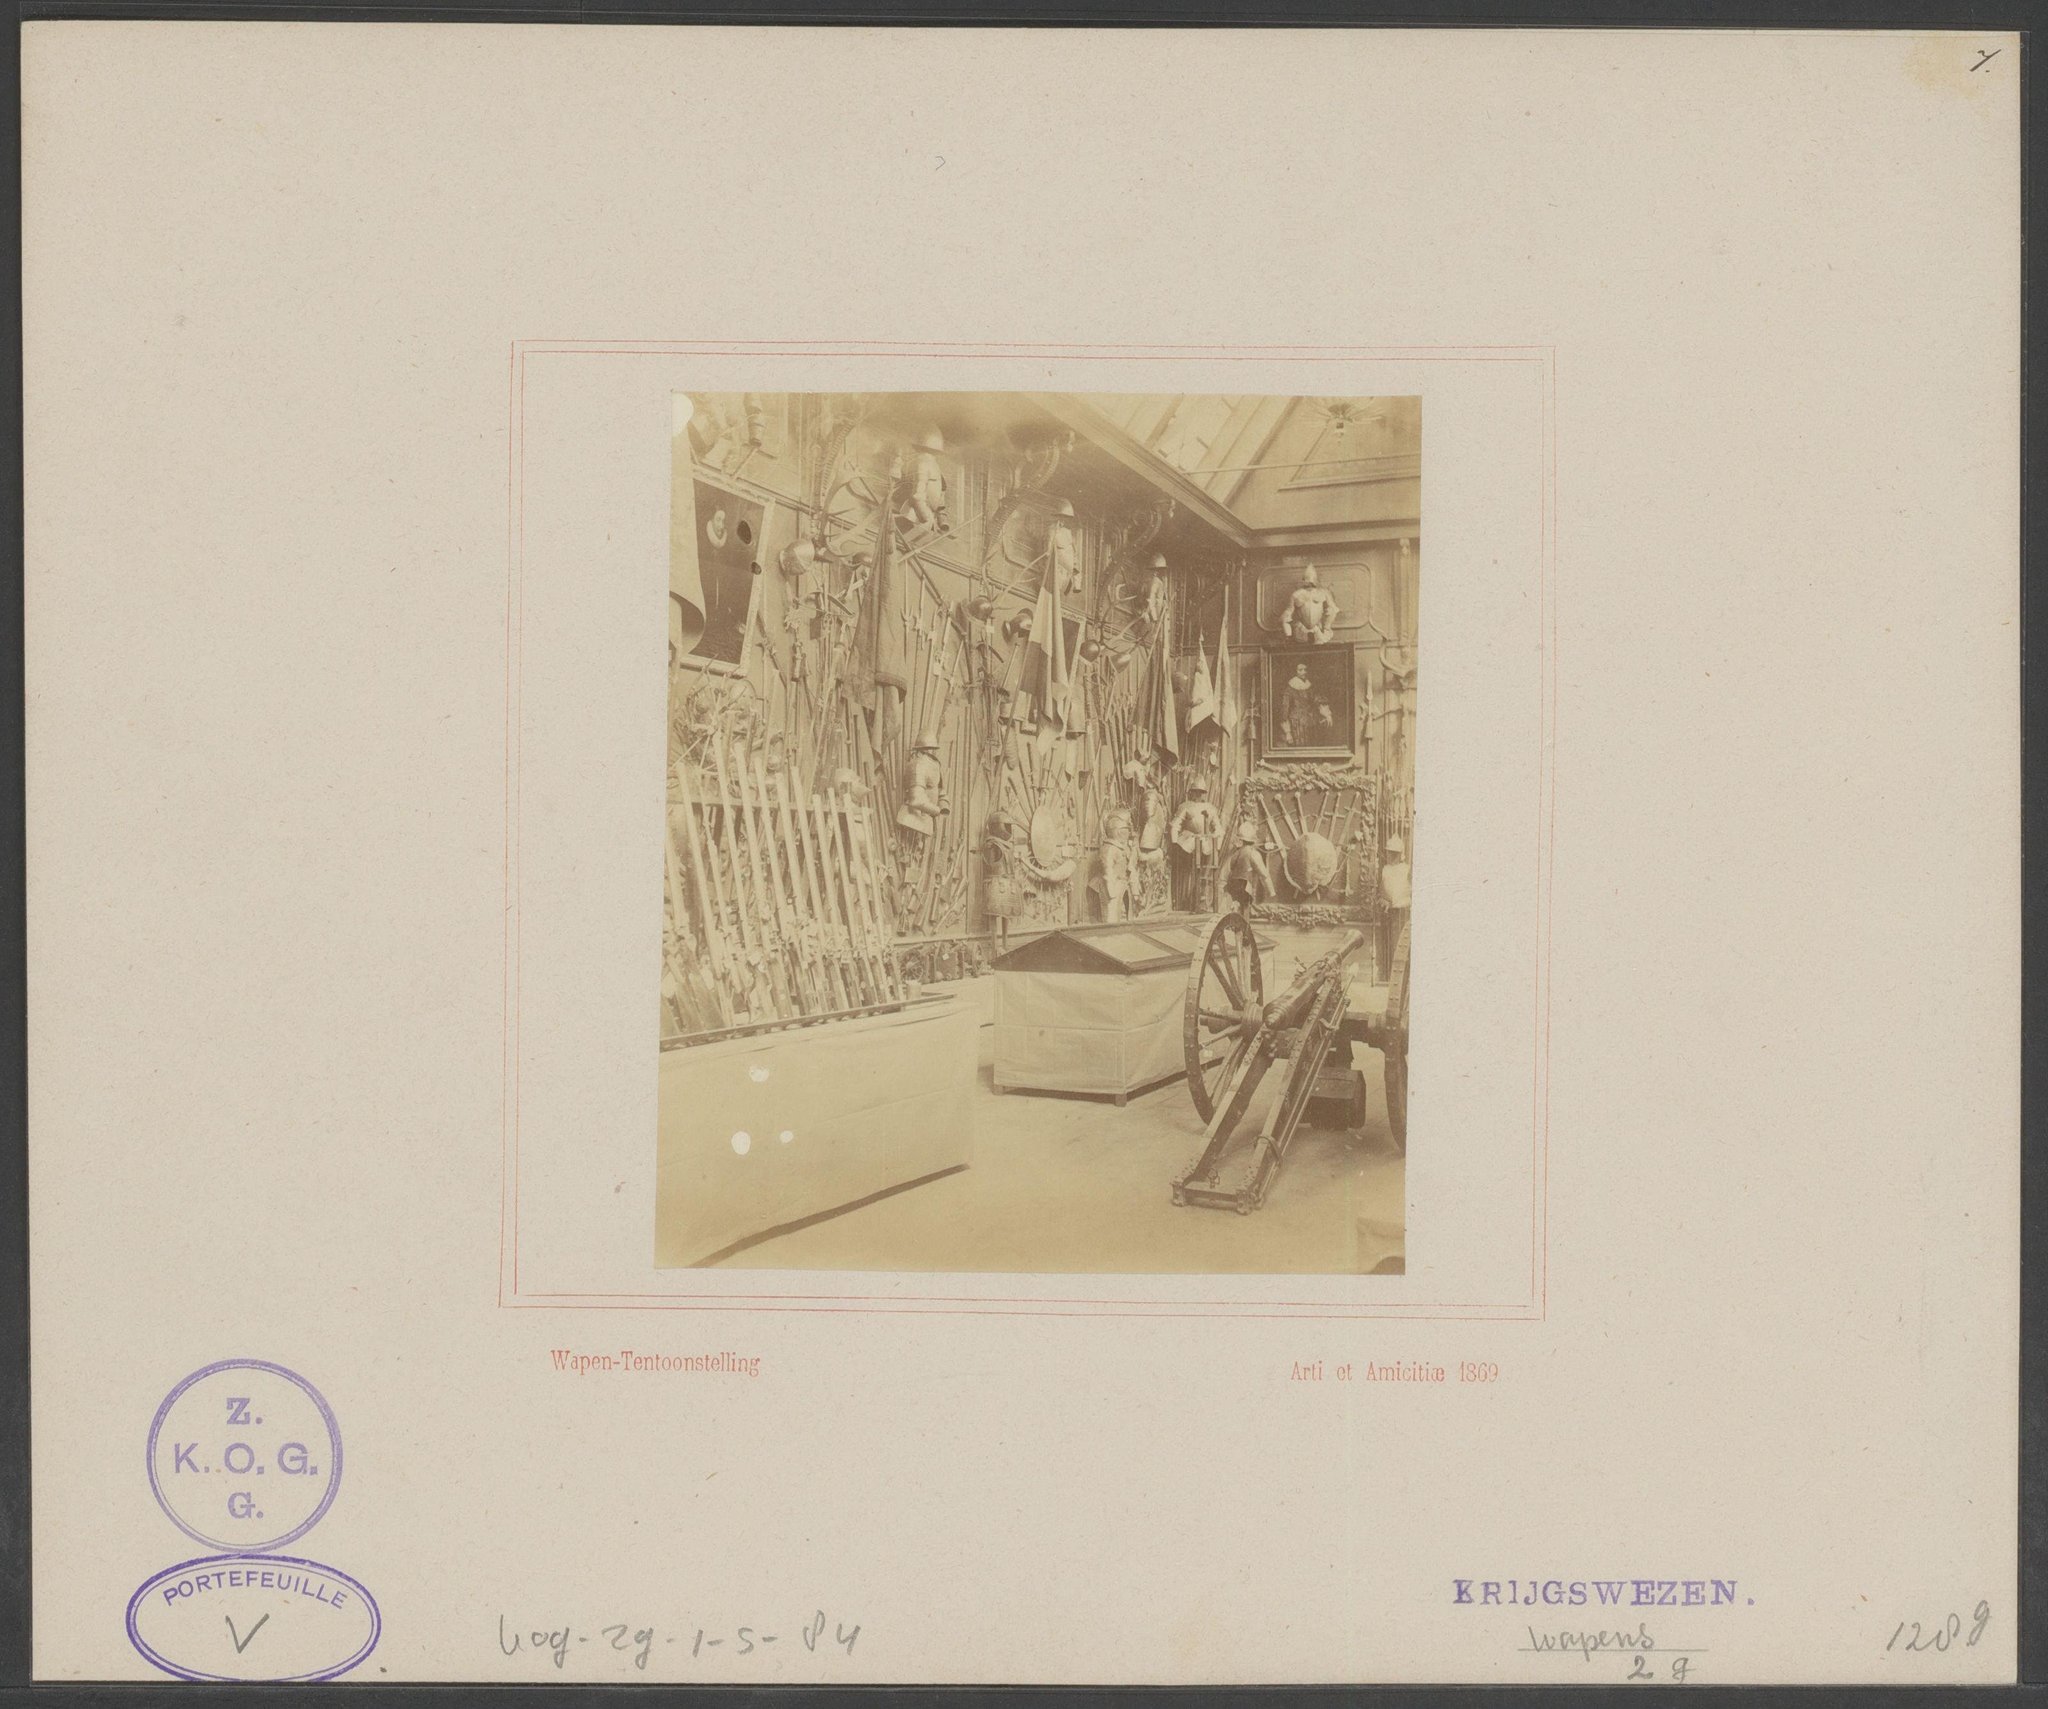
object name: photograph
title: Kanon, harnassen en wapens op de wapententoonstelling van Arti et Amicitiae, 1869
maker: Anonymous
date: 1804-1869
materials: cardboard, paper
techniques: albumen print, letterpress printing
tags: armour, hacking and thrusting weapons: sword, weapons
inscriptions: collector's mark: Lugt 1641, stamp, check stamp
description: Onderwerpsrubrieken binnen de Atlas Zeden en Gewoonten: Krijgswezen, Wapens.